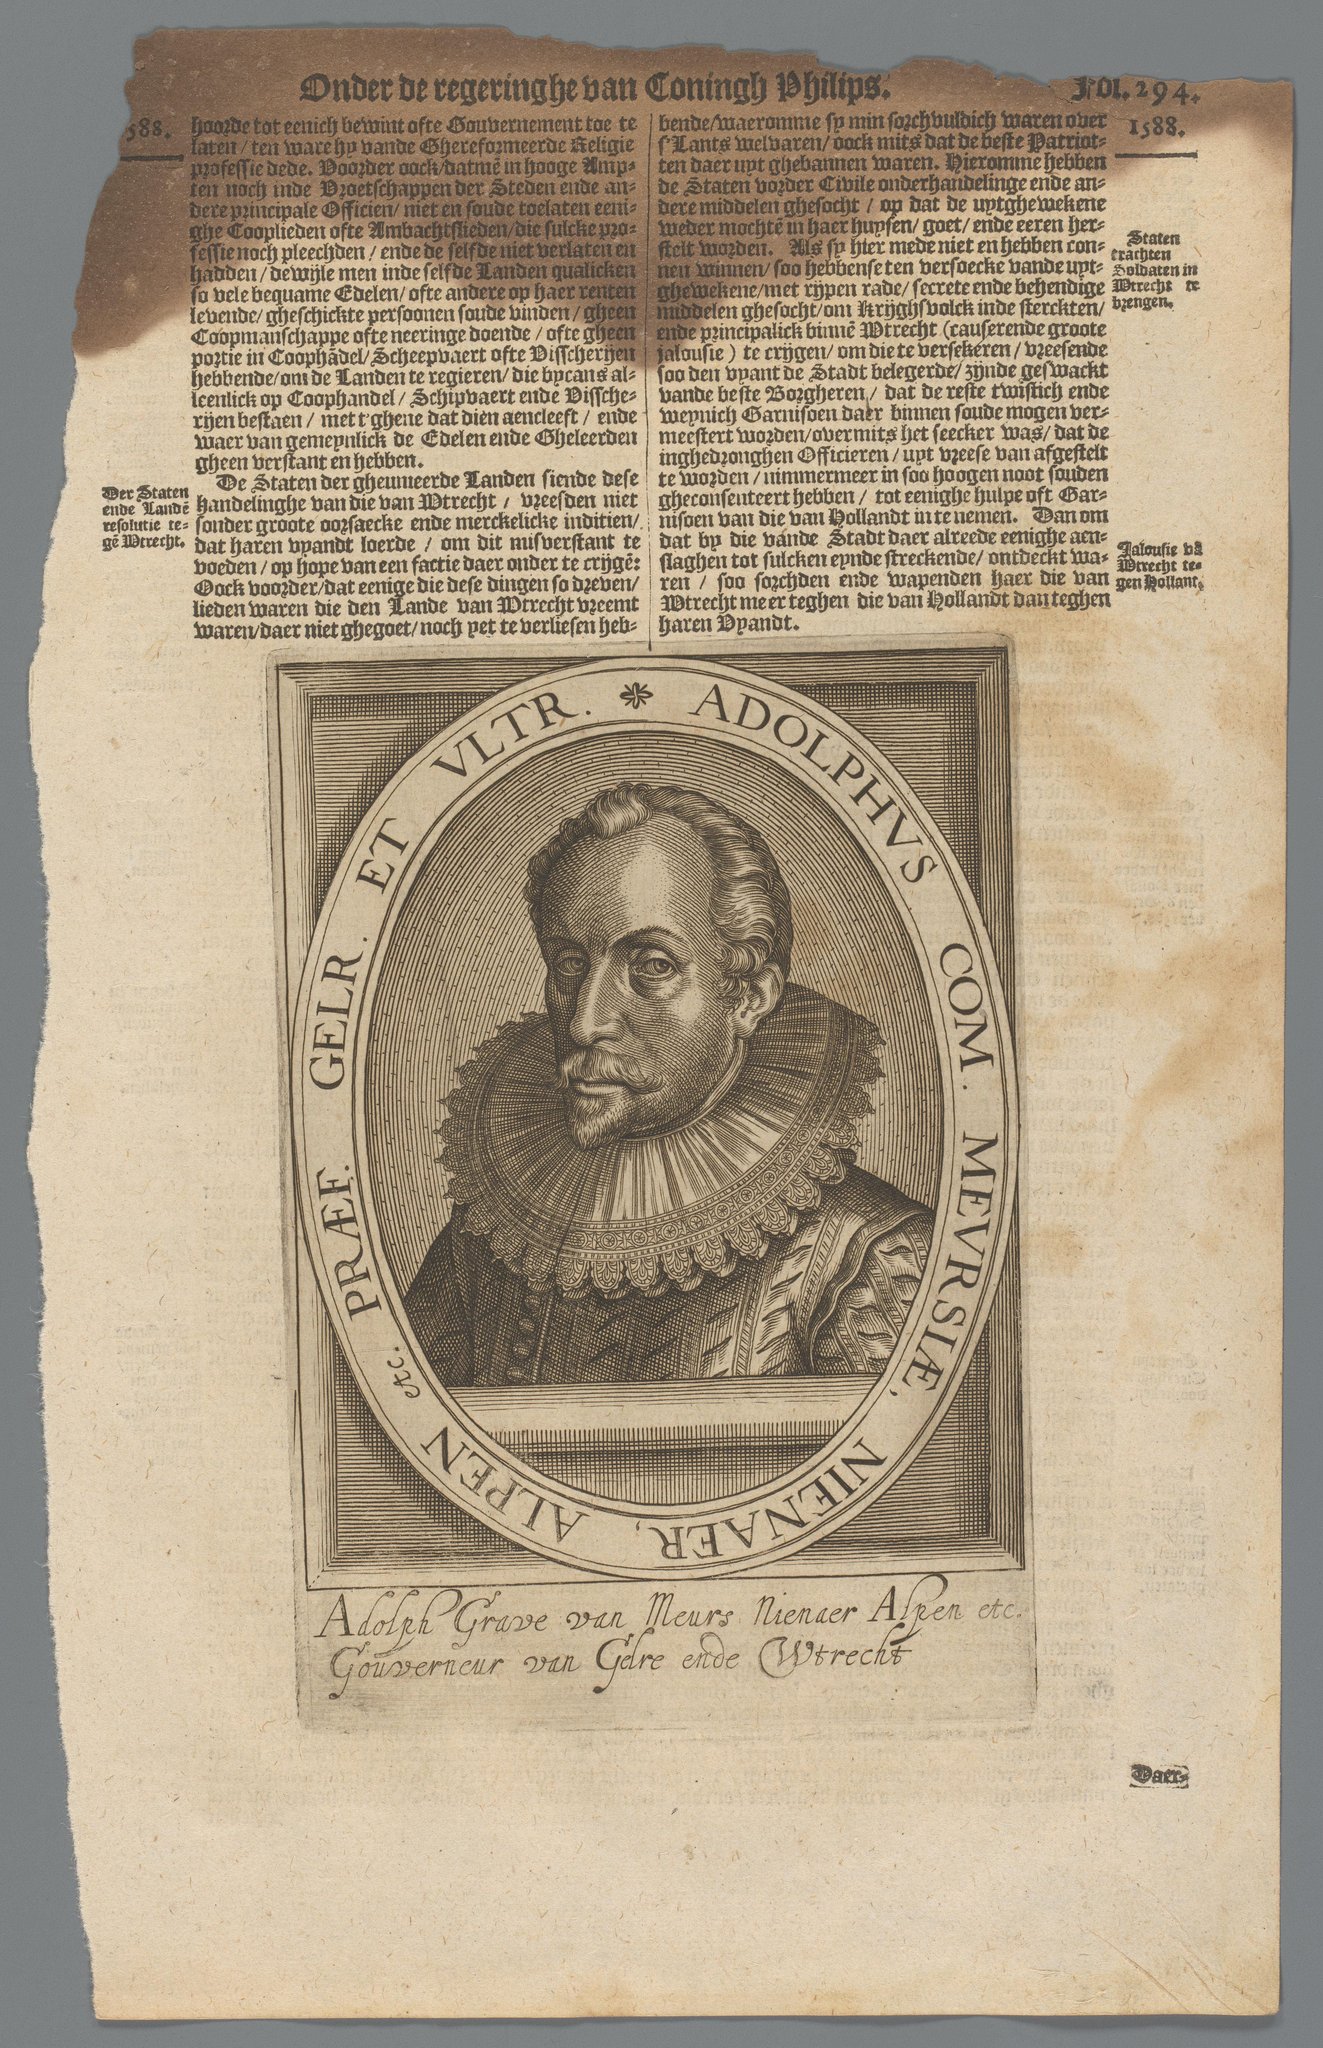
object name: print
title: Adolphus com. Meursiae Nienaer, Alpen etc. praef. Gelr. et Ultr.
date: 1614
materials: paper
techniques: engraving, letterpress printing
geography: the hague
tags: arnhem, commander-in-chief, general, marshal, historical persons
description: Prent uit: Meteren, Emanuel van. Historie der Nederlandscher ende haerder na-buren oorlogen ende geschiedenissen (...). Den Haag: Hillebrant Iacobsz. van Wouw, 1614.